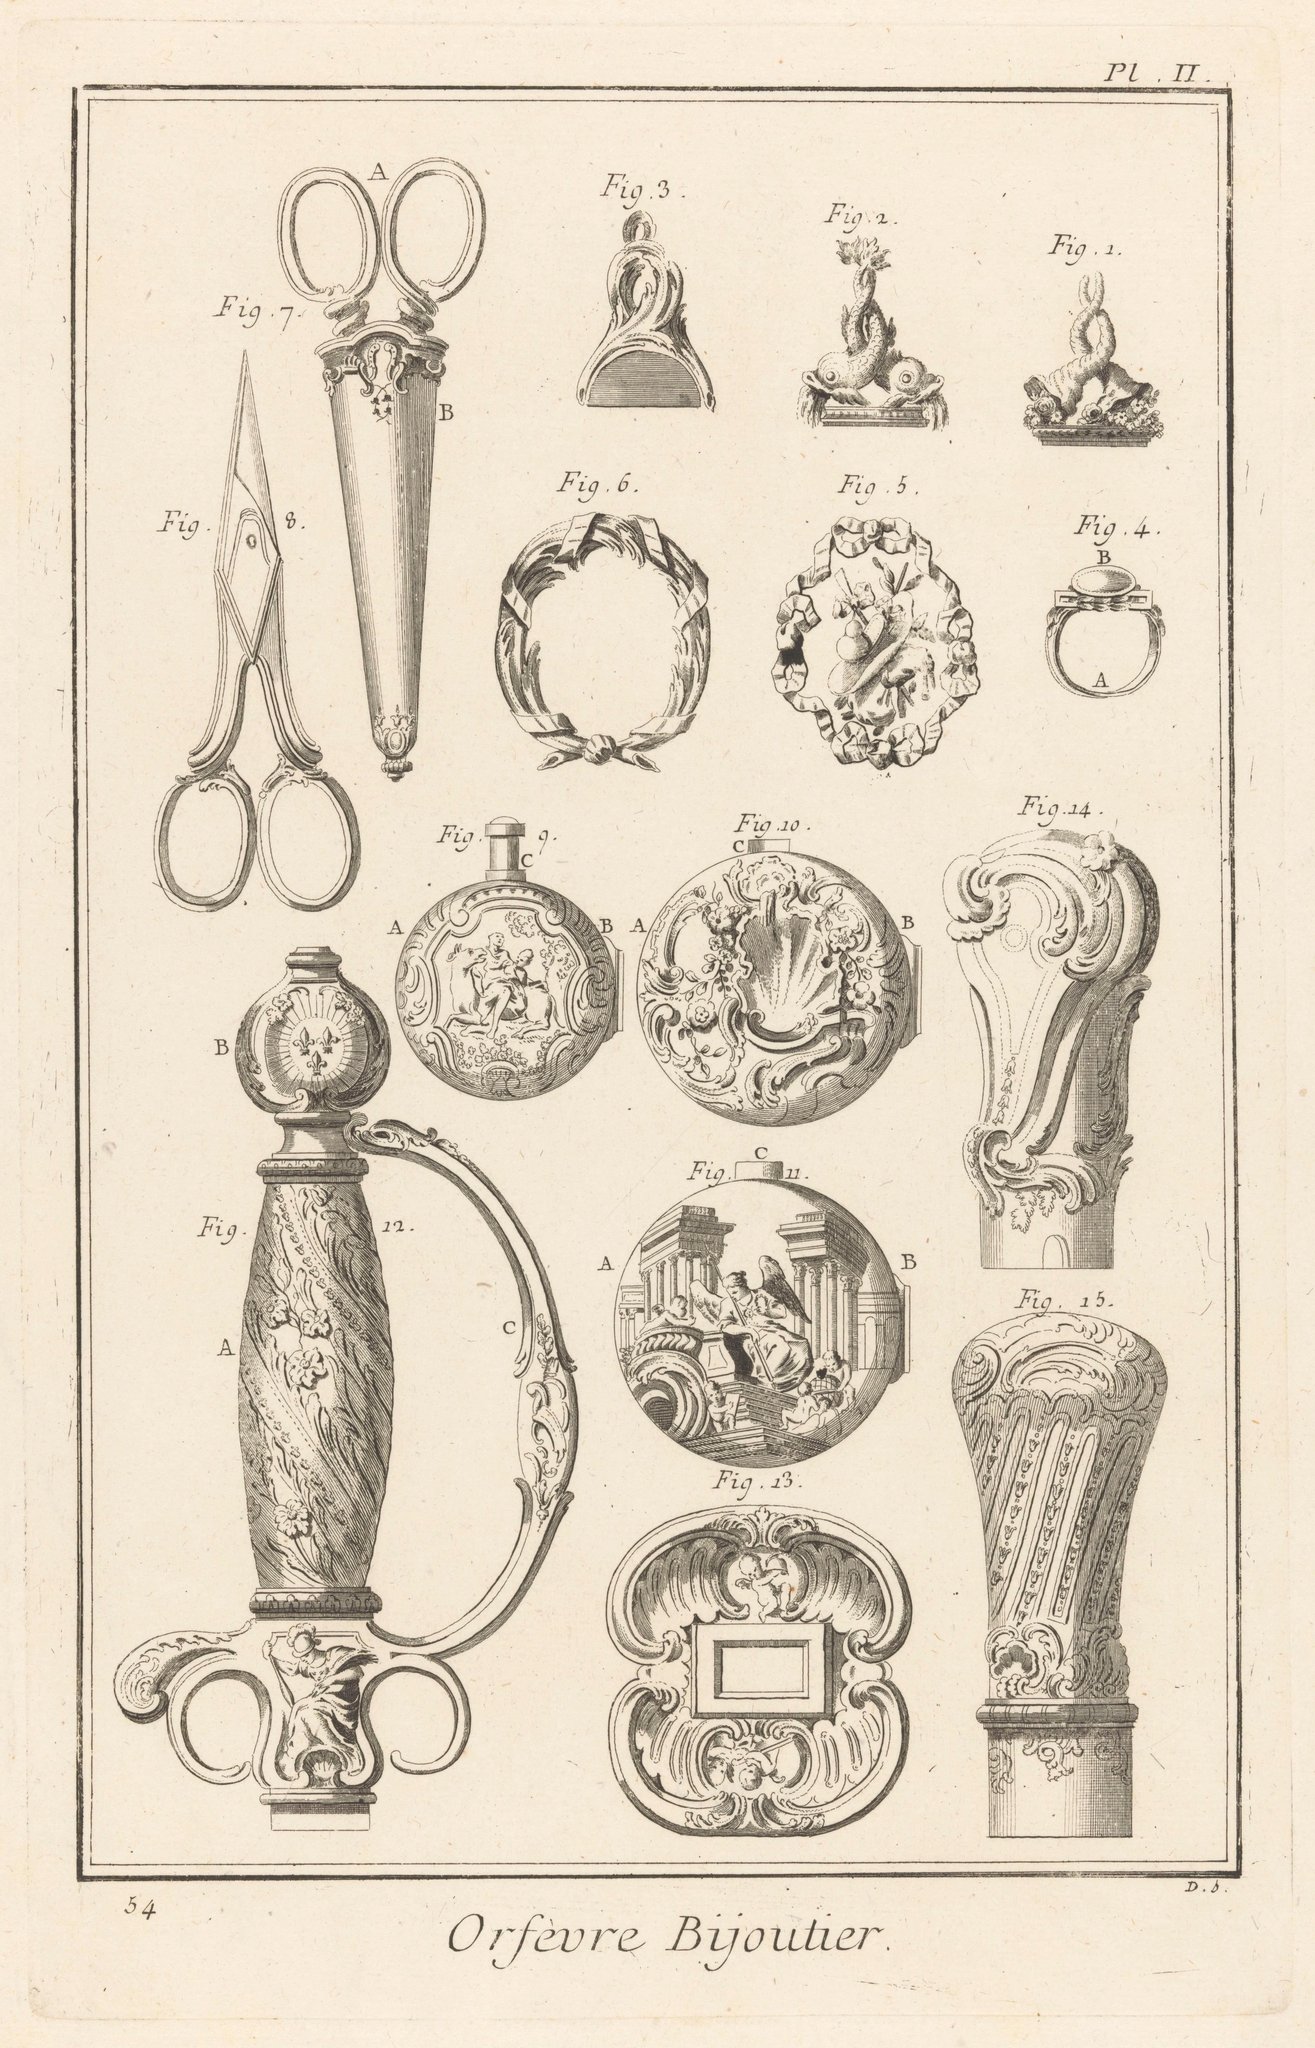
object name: ornament print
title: Orfèvre Bijoutier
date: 1770-1780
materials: paper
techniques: engraving, etching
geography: yverdon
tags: jeweller, goldsmith, silversmith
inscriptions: collector's mark: Lugt 2228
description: Prent uit: Diderot, Denis en d'Alembert, Jean Baptiste le Rond. Encyclopédie ou dictionnaire universel raisonné des connoissances humaines. Yverdon: Felice, Fortunatio Bartolomeo de, 1770-1780. Pagina 54.